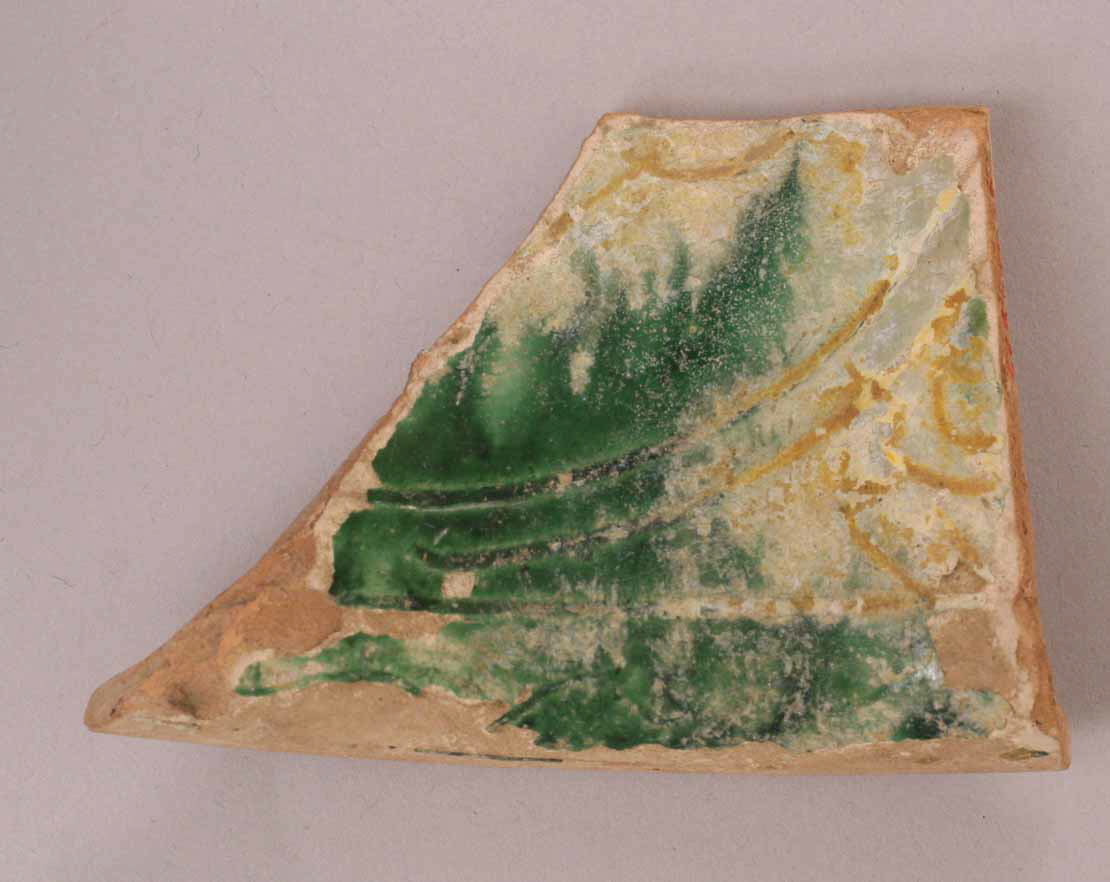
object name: fragment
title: Ceramic Fragment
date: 701-900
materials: earthenware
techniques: glazing, incising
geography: iraq